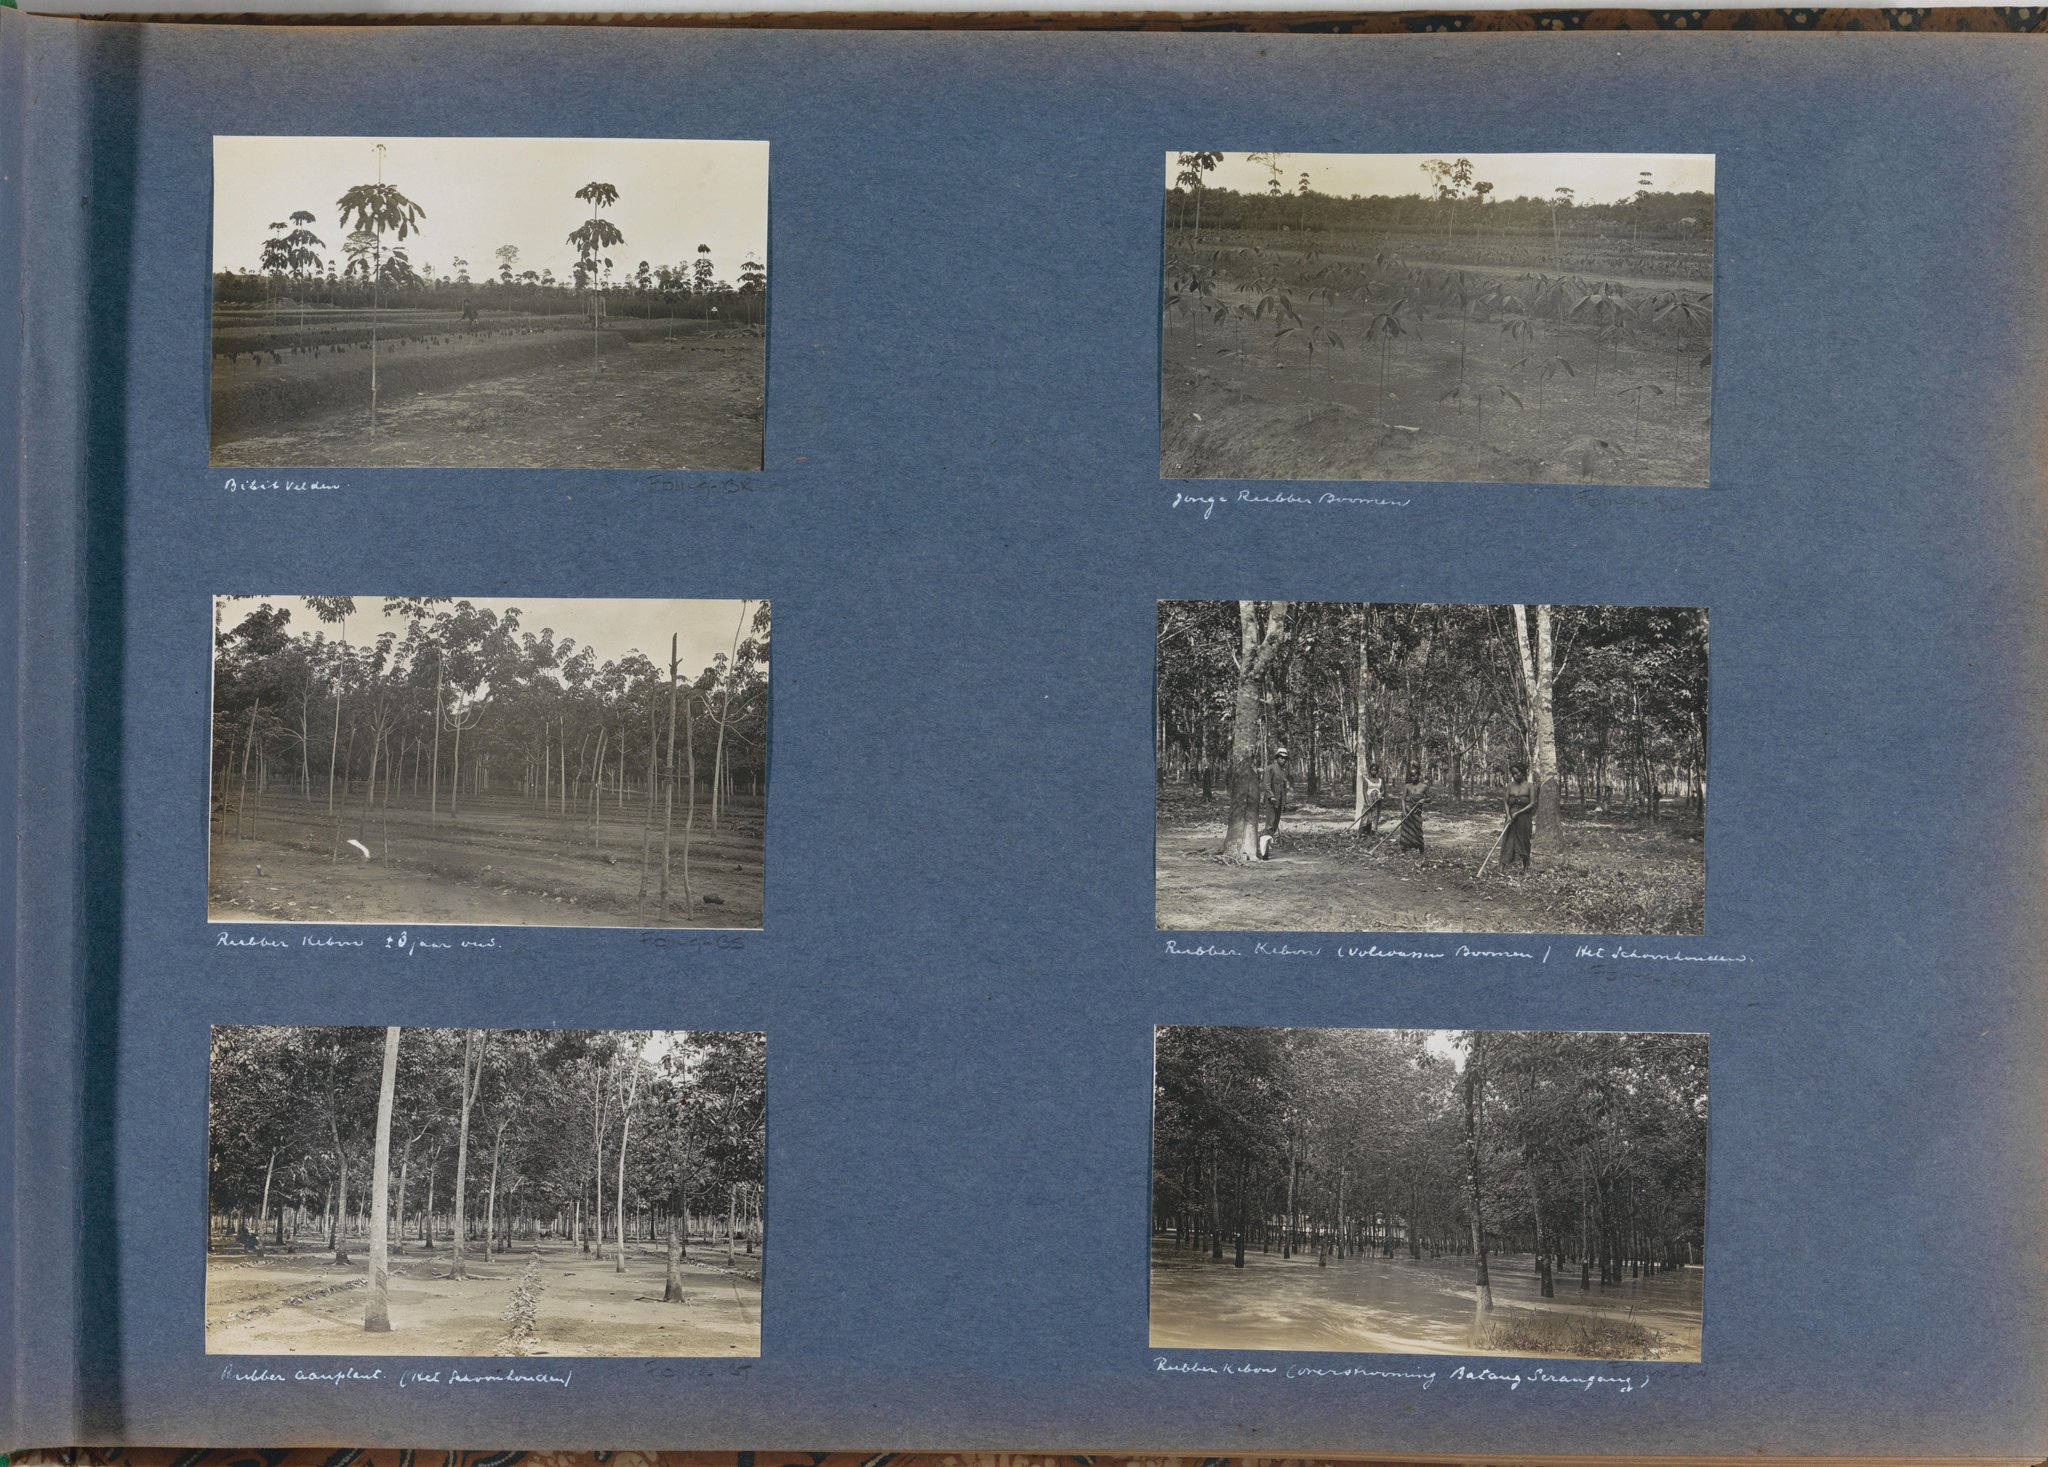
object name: album leaf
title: Rubberaanplant tussen aangeharkte paden op een rubberplantage op Sumatra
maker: Anonymous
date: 1900-1920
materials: paper, photographic support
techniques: gelatin silver print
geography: sumatra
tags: plantation, (non-fruit) products of plants or trees: rubber, sumatra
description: Onderdeel van reisalbum met foto's van bedrijvigheid en bezienswaardigheden op Sumatra en Java en van de reis naar en van Nederlands-Indië.